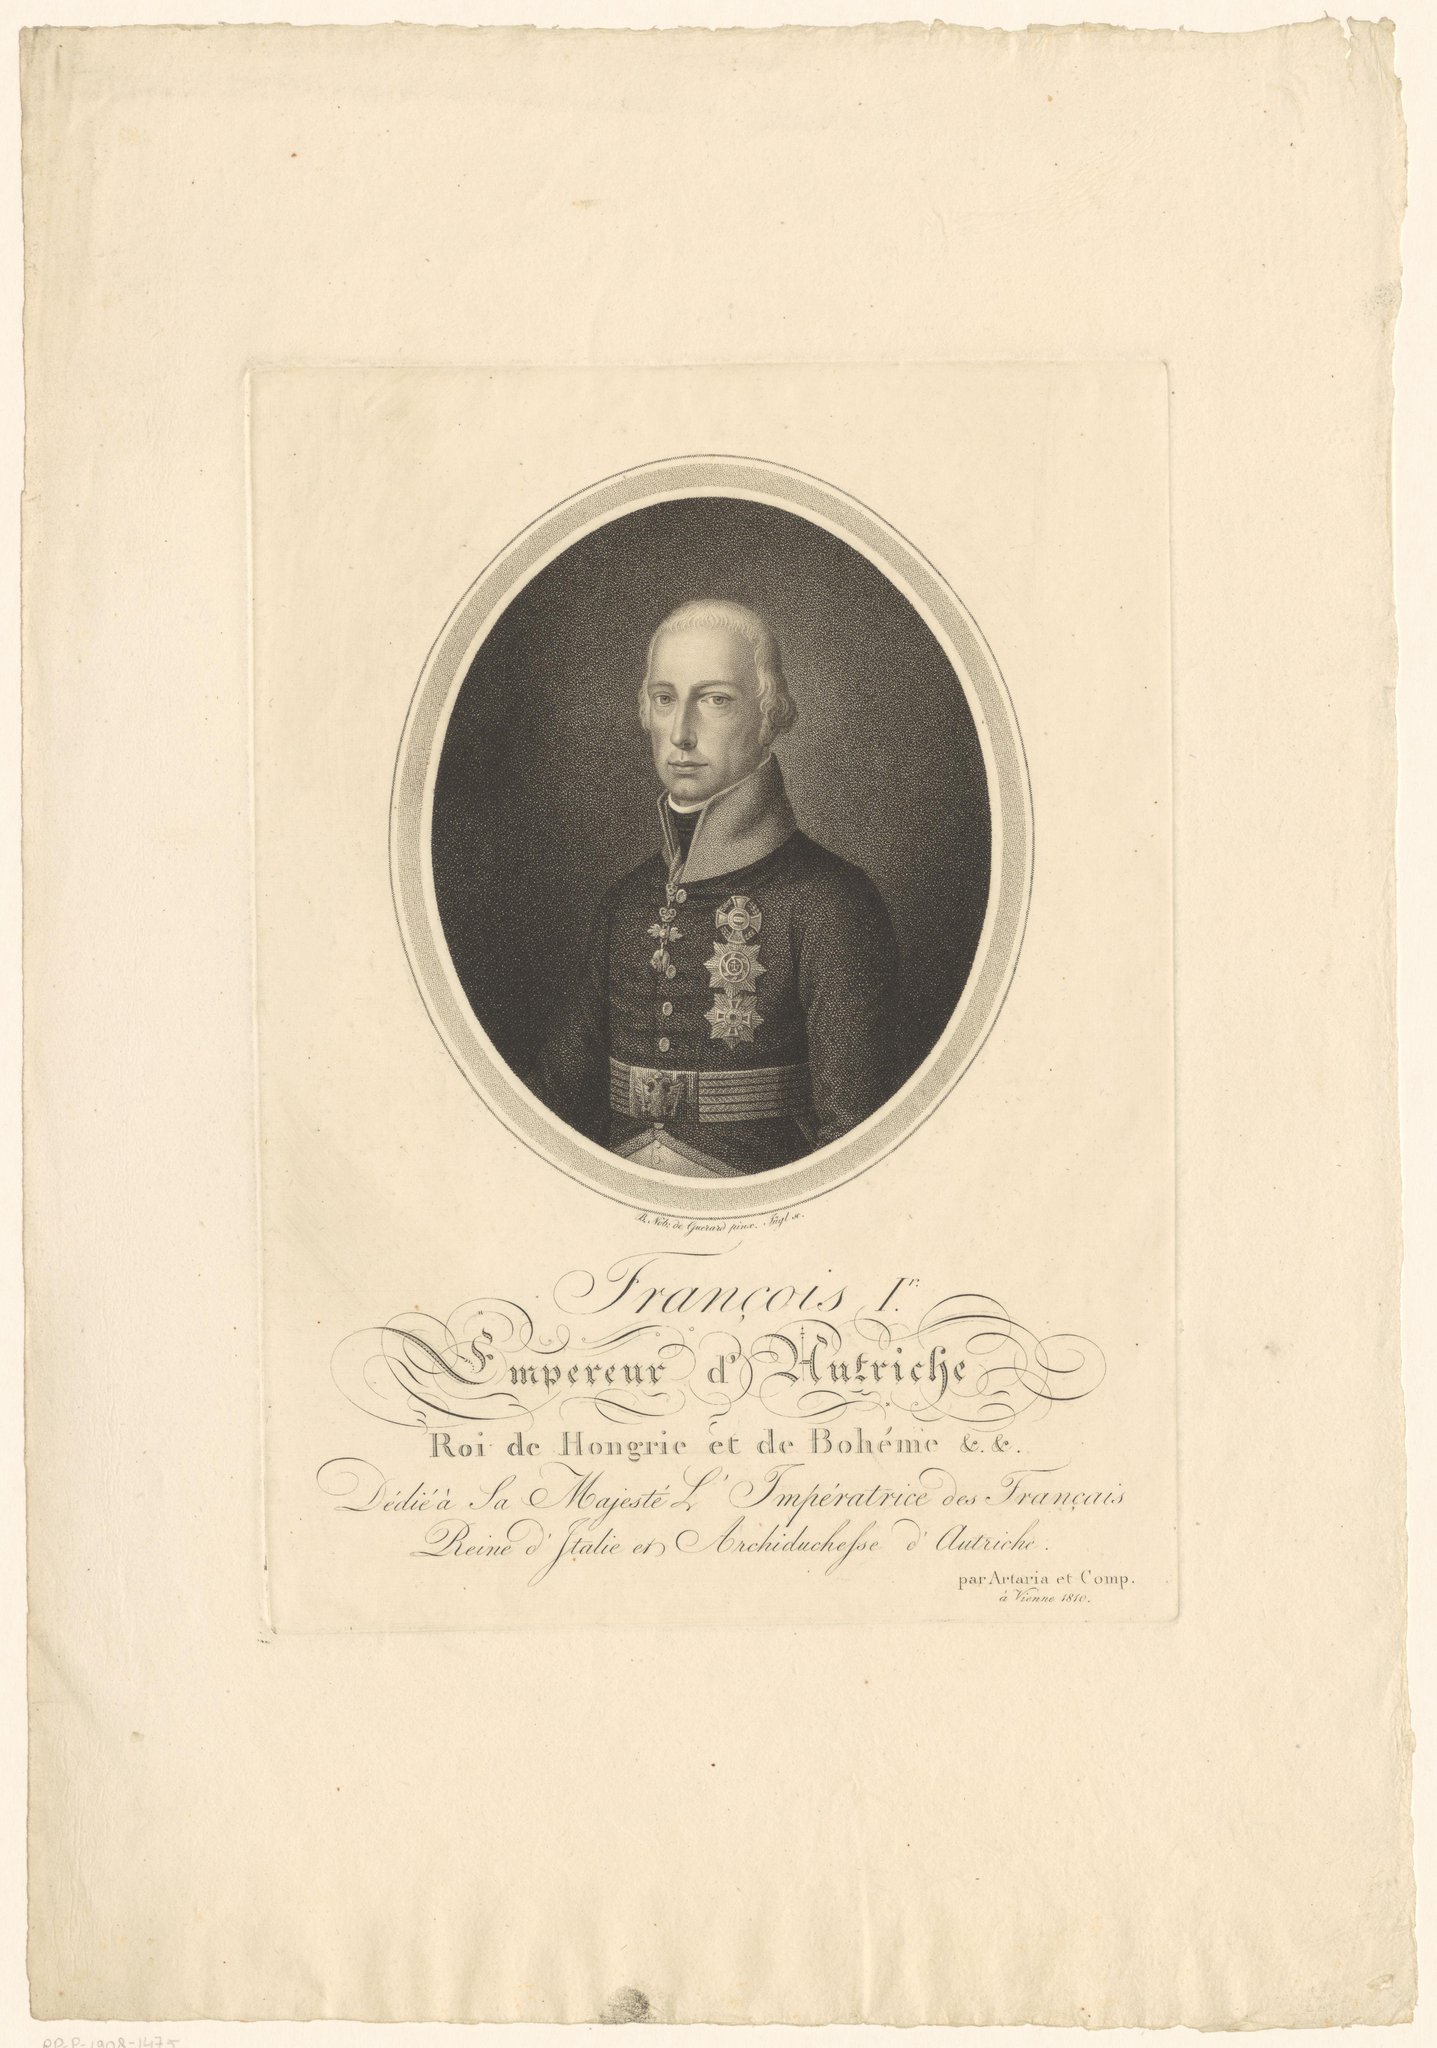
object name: print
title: Portret van Frans II Josef Karel, Rooms-Duits keizer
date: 1810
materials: paper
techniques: stippling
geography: vienna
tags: vienna, frans ii (rooms-duits keizer), knighthood order: teutonic order - insignia of a knighthood order, e.g.: badge, chain (with name of order), historical persons, medals and other marks of military honour, ruler, sovereign, knighthood order of the golden fleece - insignia of a knighthood order, e.g.: badge, chain (with name of order)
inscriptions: collector's mark: Lugt 2228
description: Tekst in het Frans onder het ovale medaillon.